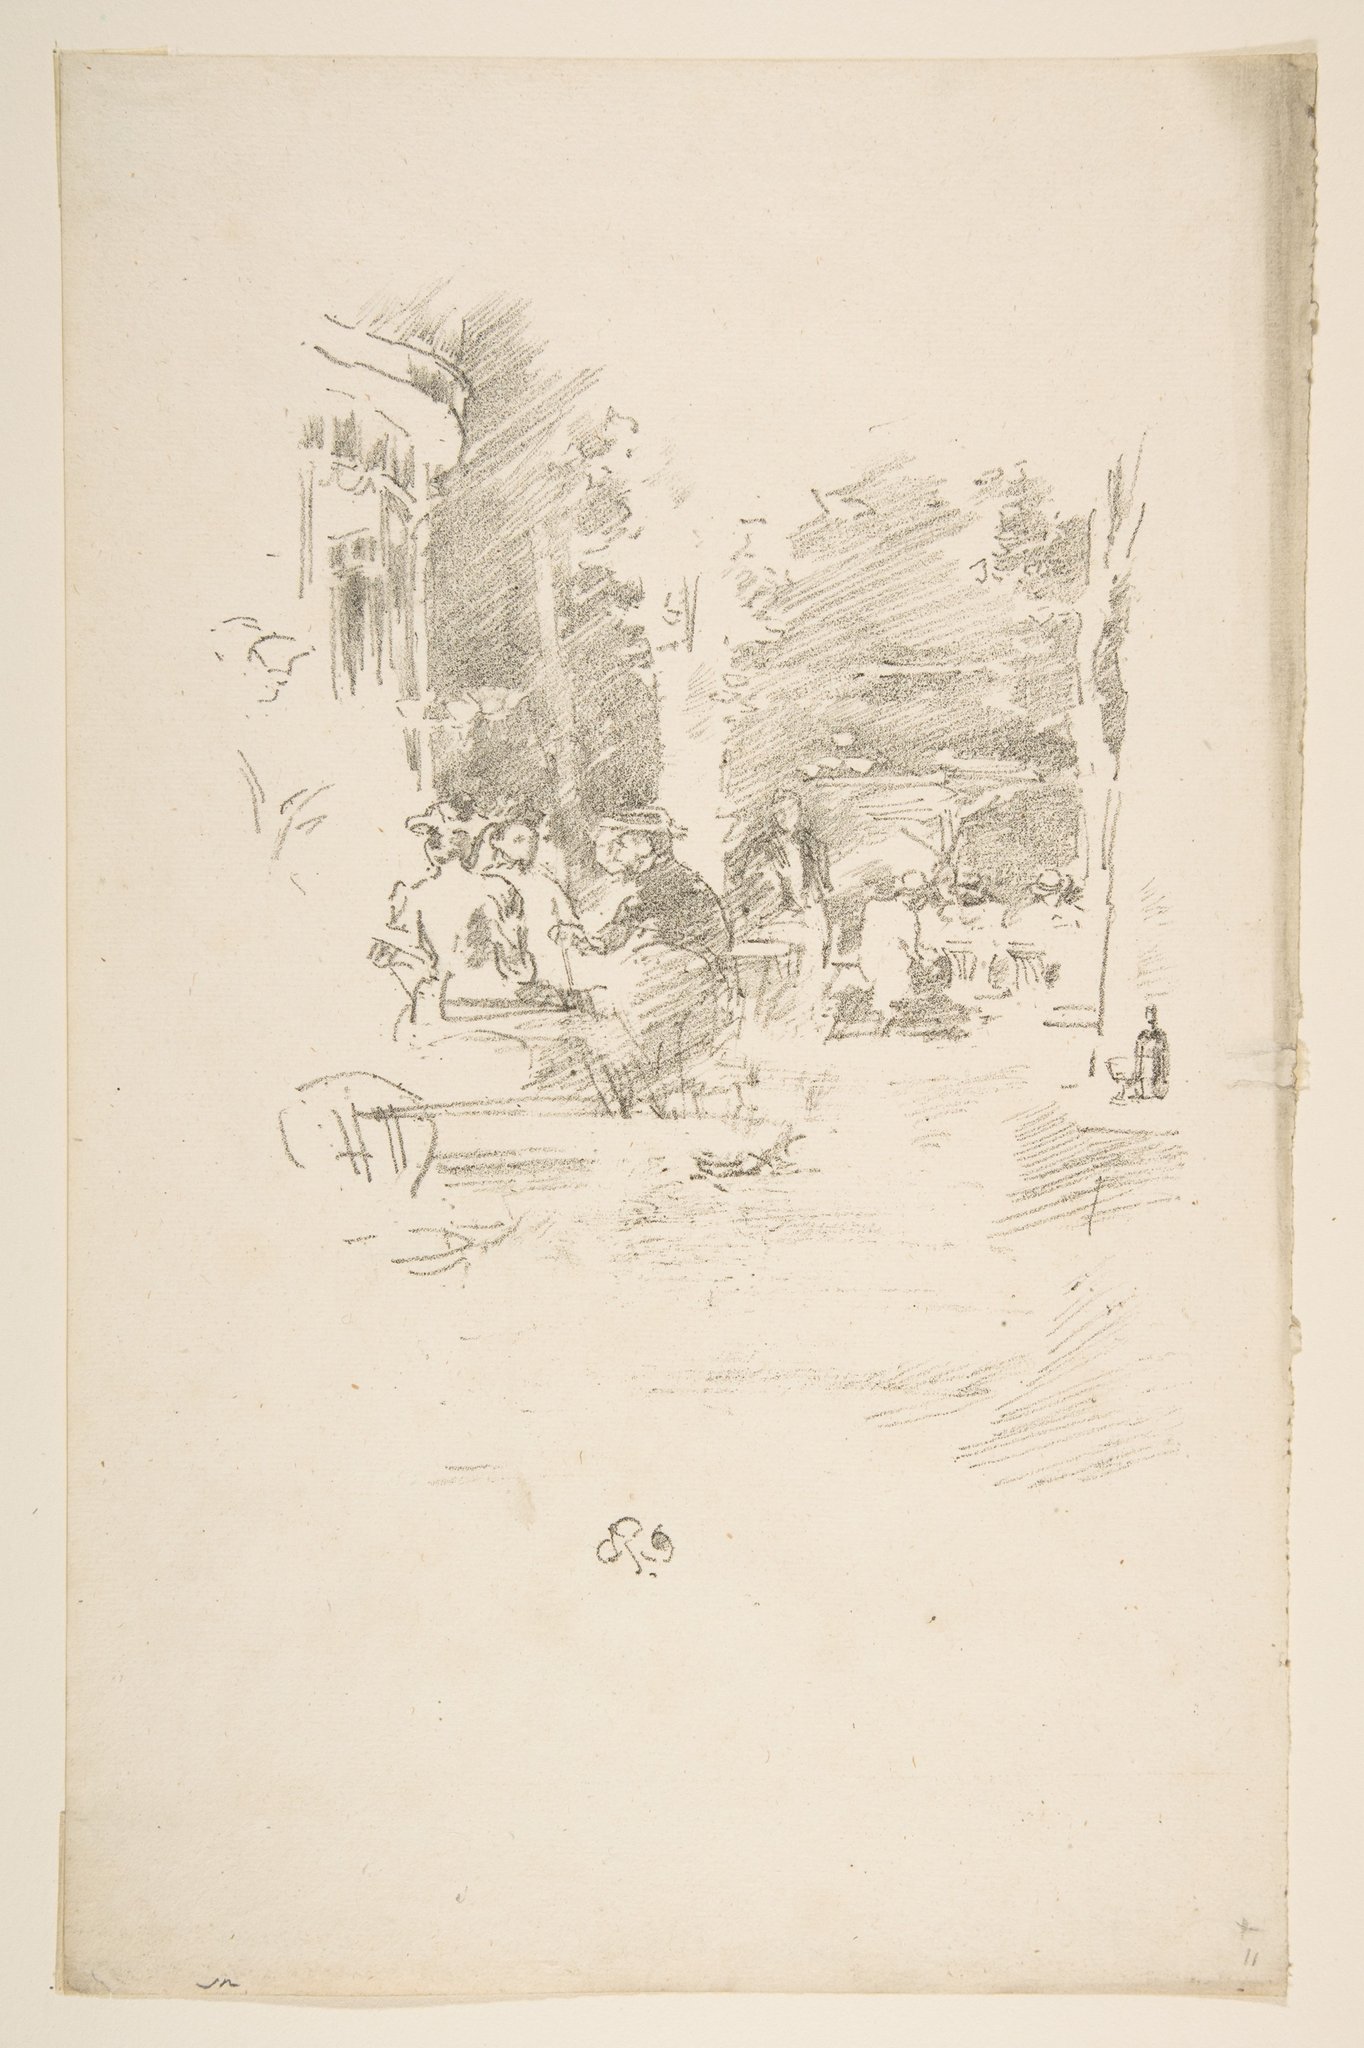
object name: print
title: The Little Café au Bois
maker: james mcneill whistler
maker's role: artist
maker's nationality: american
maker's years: 1834-1903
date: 1894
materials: ink, paper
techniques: printing, lithography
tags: men,women,cafe